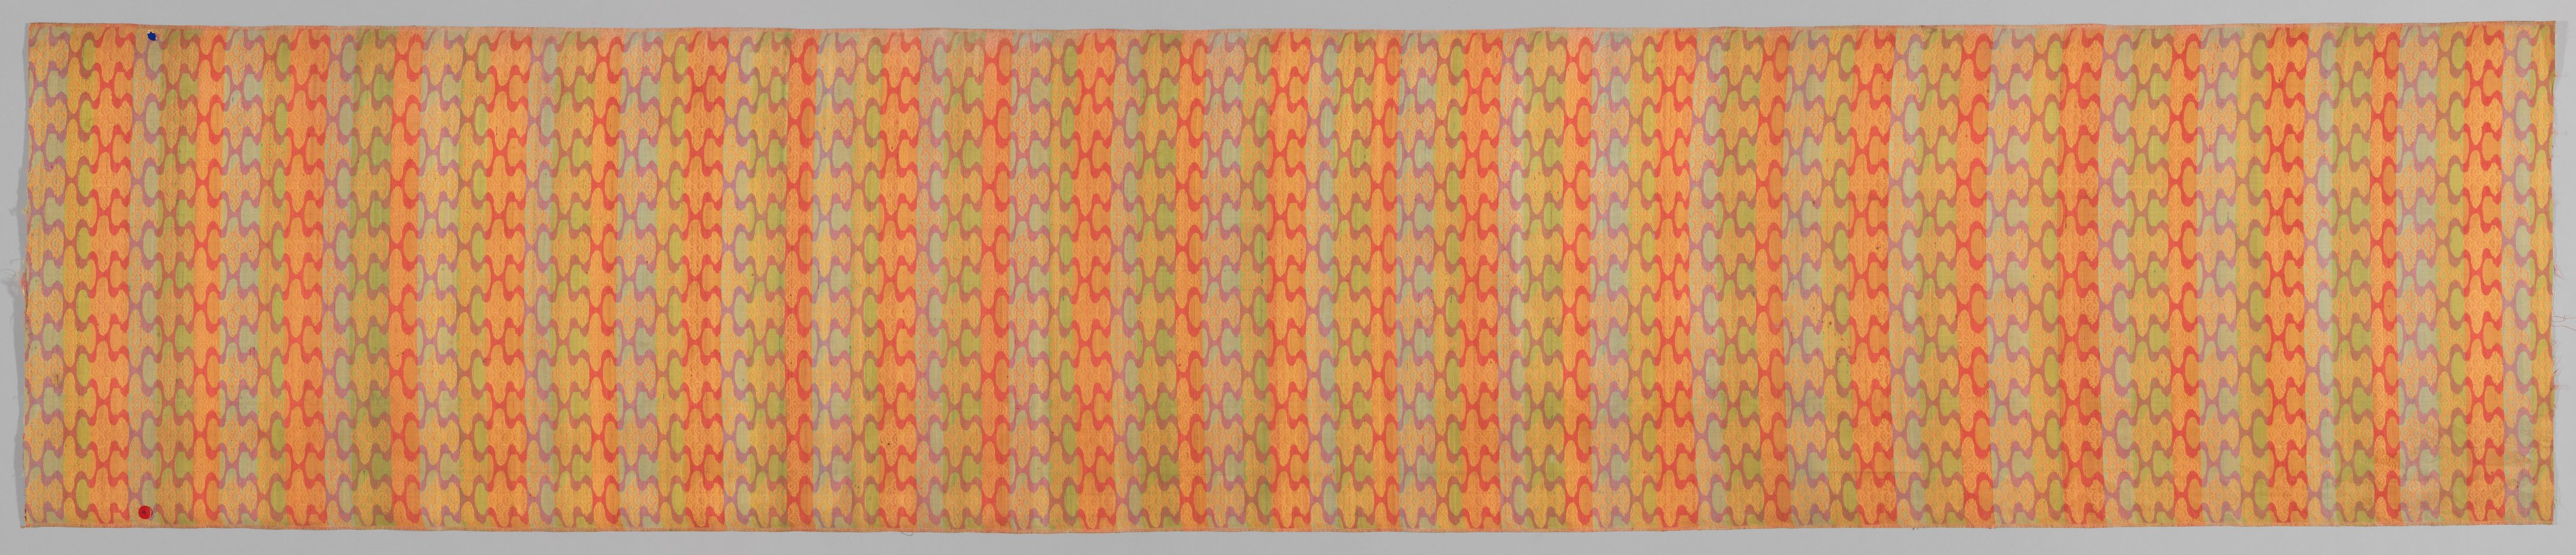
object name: baan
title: Baan zijdedamast met een dessin van een doorlopend golfpatroon in horizontale banen, gedeeltelijk gevuld met om en om van richting wisselend dessin van geschakelde cirkels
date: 1900-1920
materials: silk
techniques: damask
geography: japan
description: Baan zijdedamast met een dessin van een doorlopend golfpatroon in horizontale banen, gedeeltelijk gevuld met om en om van richting wisselend dessin van geschakelde concentrische cirkels. Kleuren: geel, hardroze, groen, oranjeroze en blauw. Oosterse textiel.